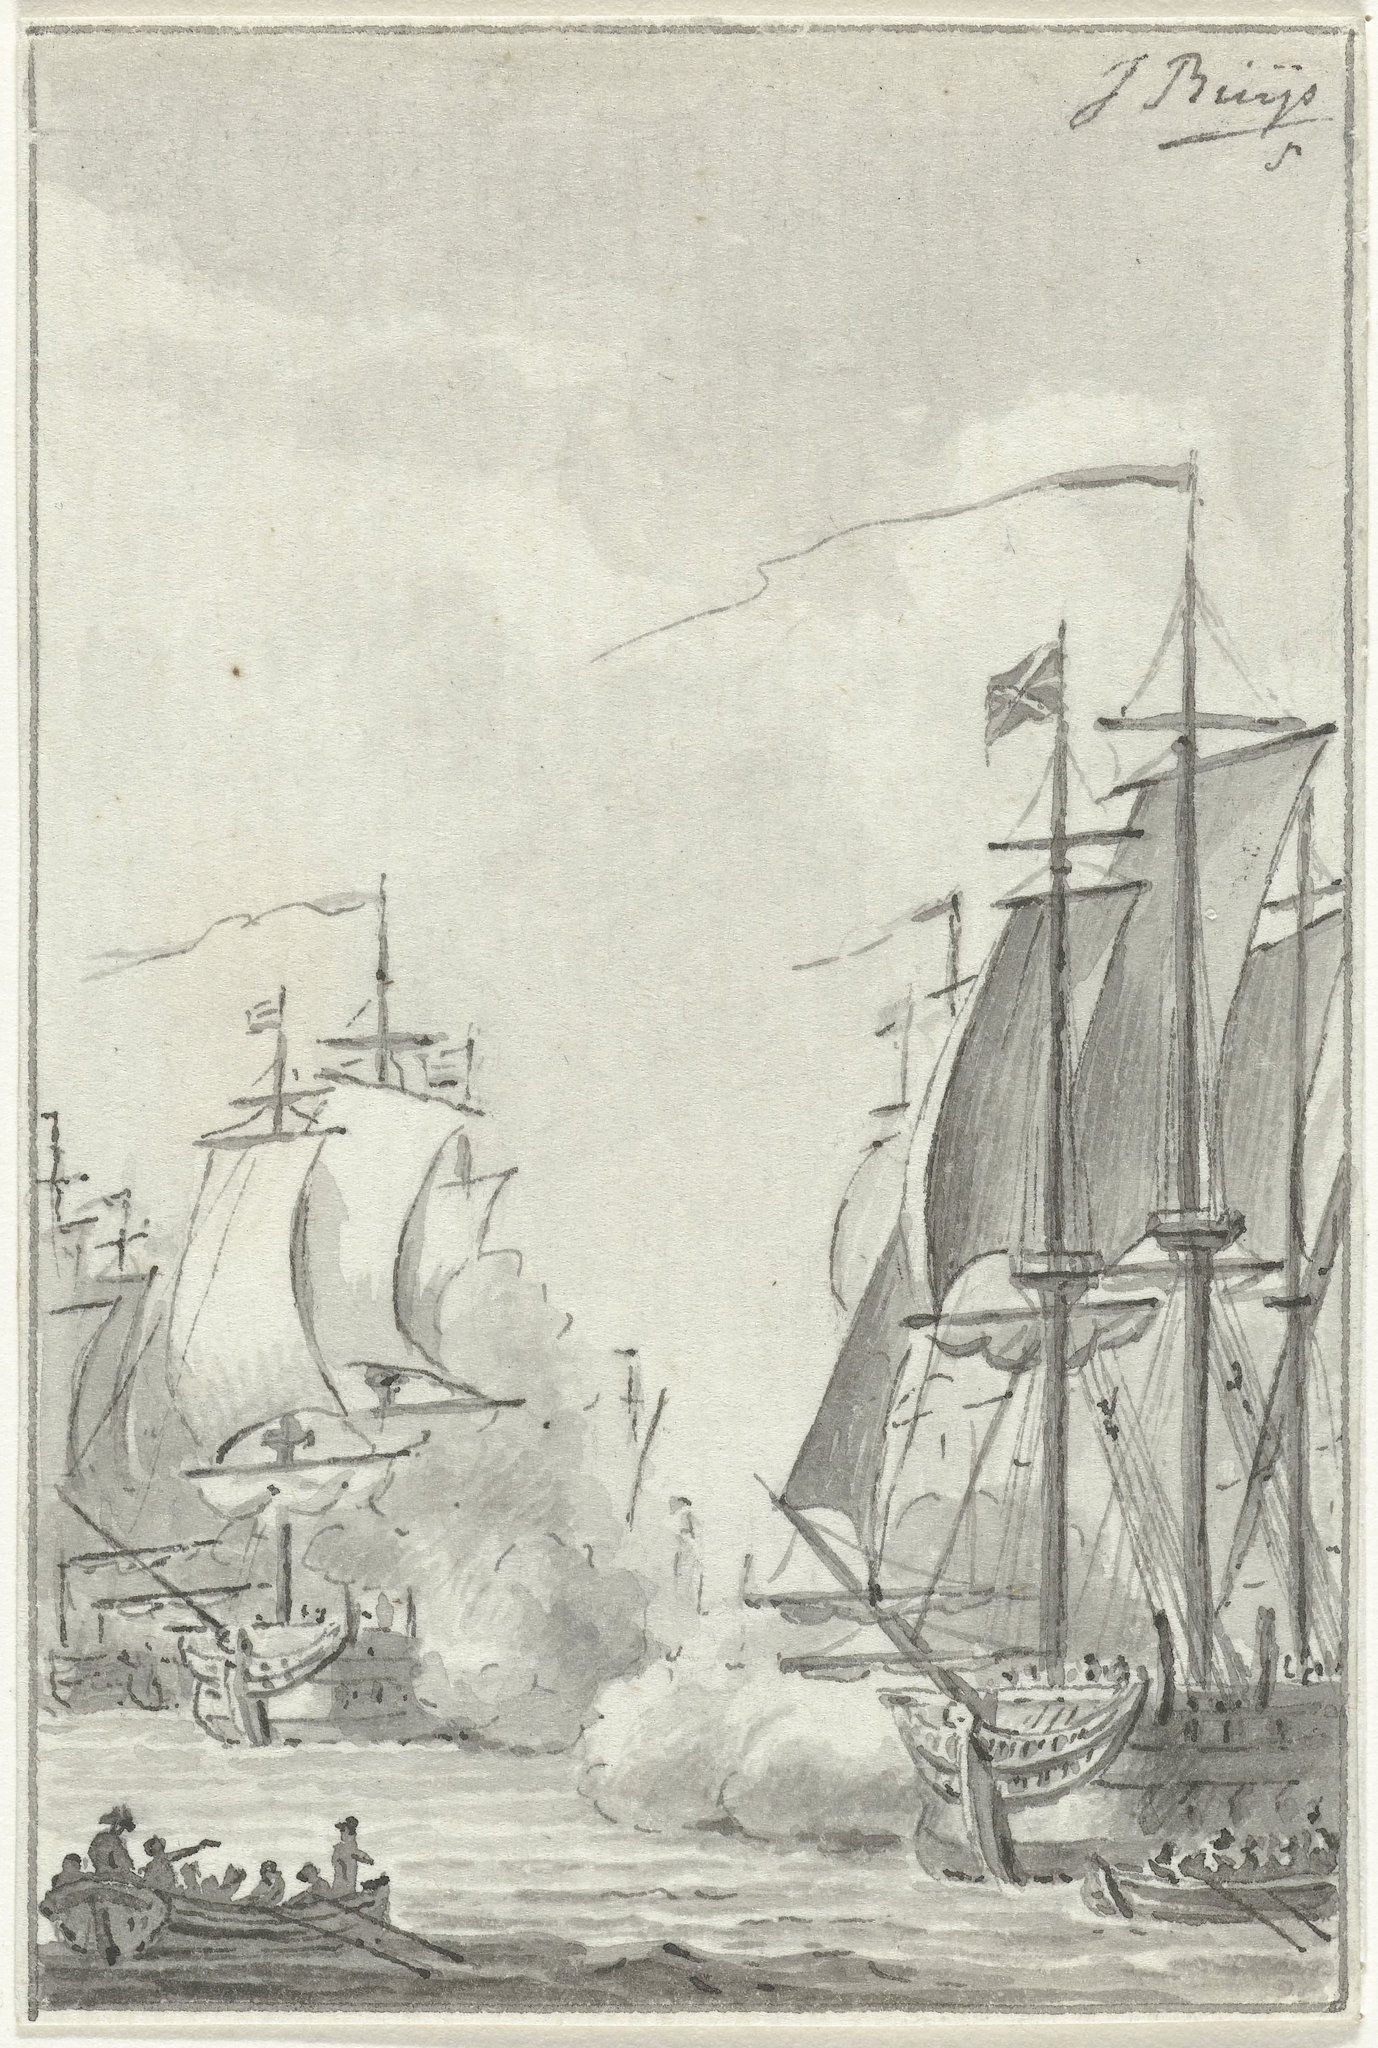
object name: design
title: Treffen tussen Fielding en Van Bylandt, 1779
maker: jacobus buys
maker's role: draughtsman, print maker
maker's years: 1724-1801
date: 1780-1795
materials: ink, paper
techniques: brush, pen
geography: northern netherlands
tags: battle (+ naval force)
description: Treffen tussen een Engels eskader onder bevelhebber Charles Fielding en een Nederlands eskader onder Lodewijk van Bylandt dat een konvooi begeleidde, bij Isle of Wight op 31 december 1779. Ontwerp voor een prent.